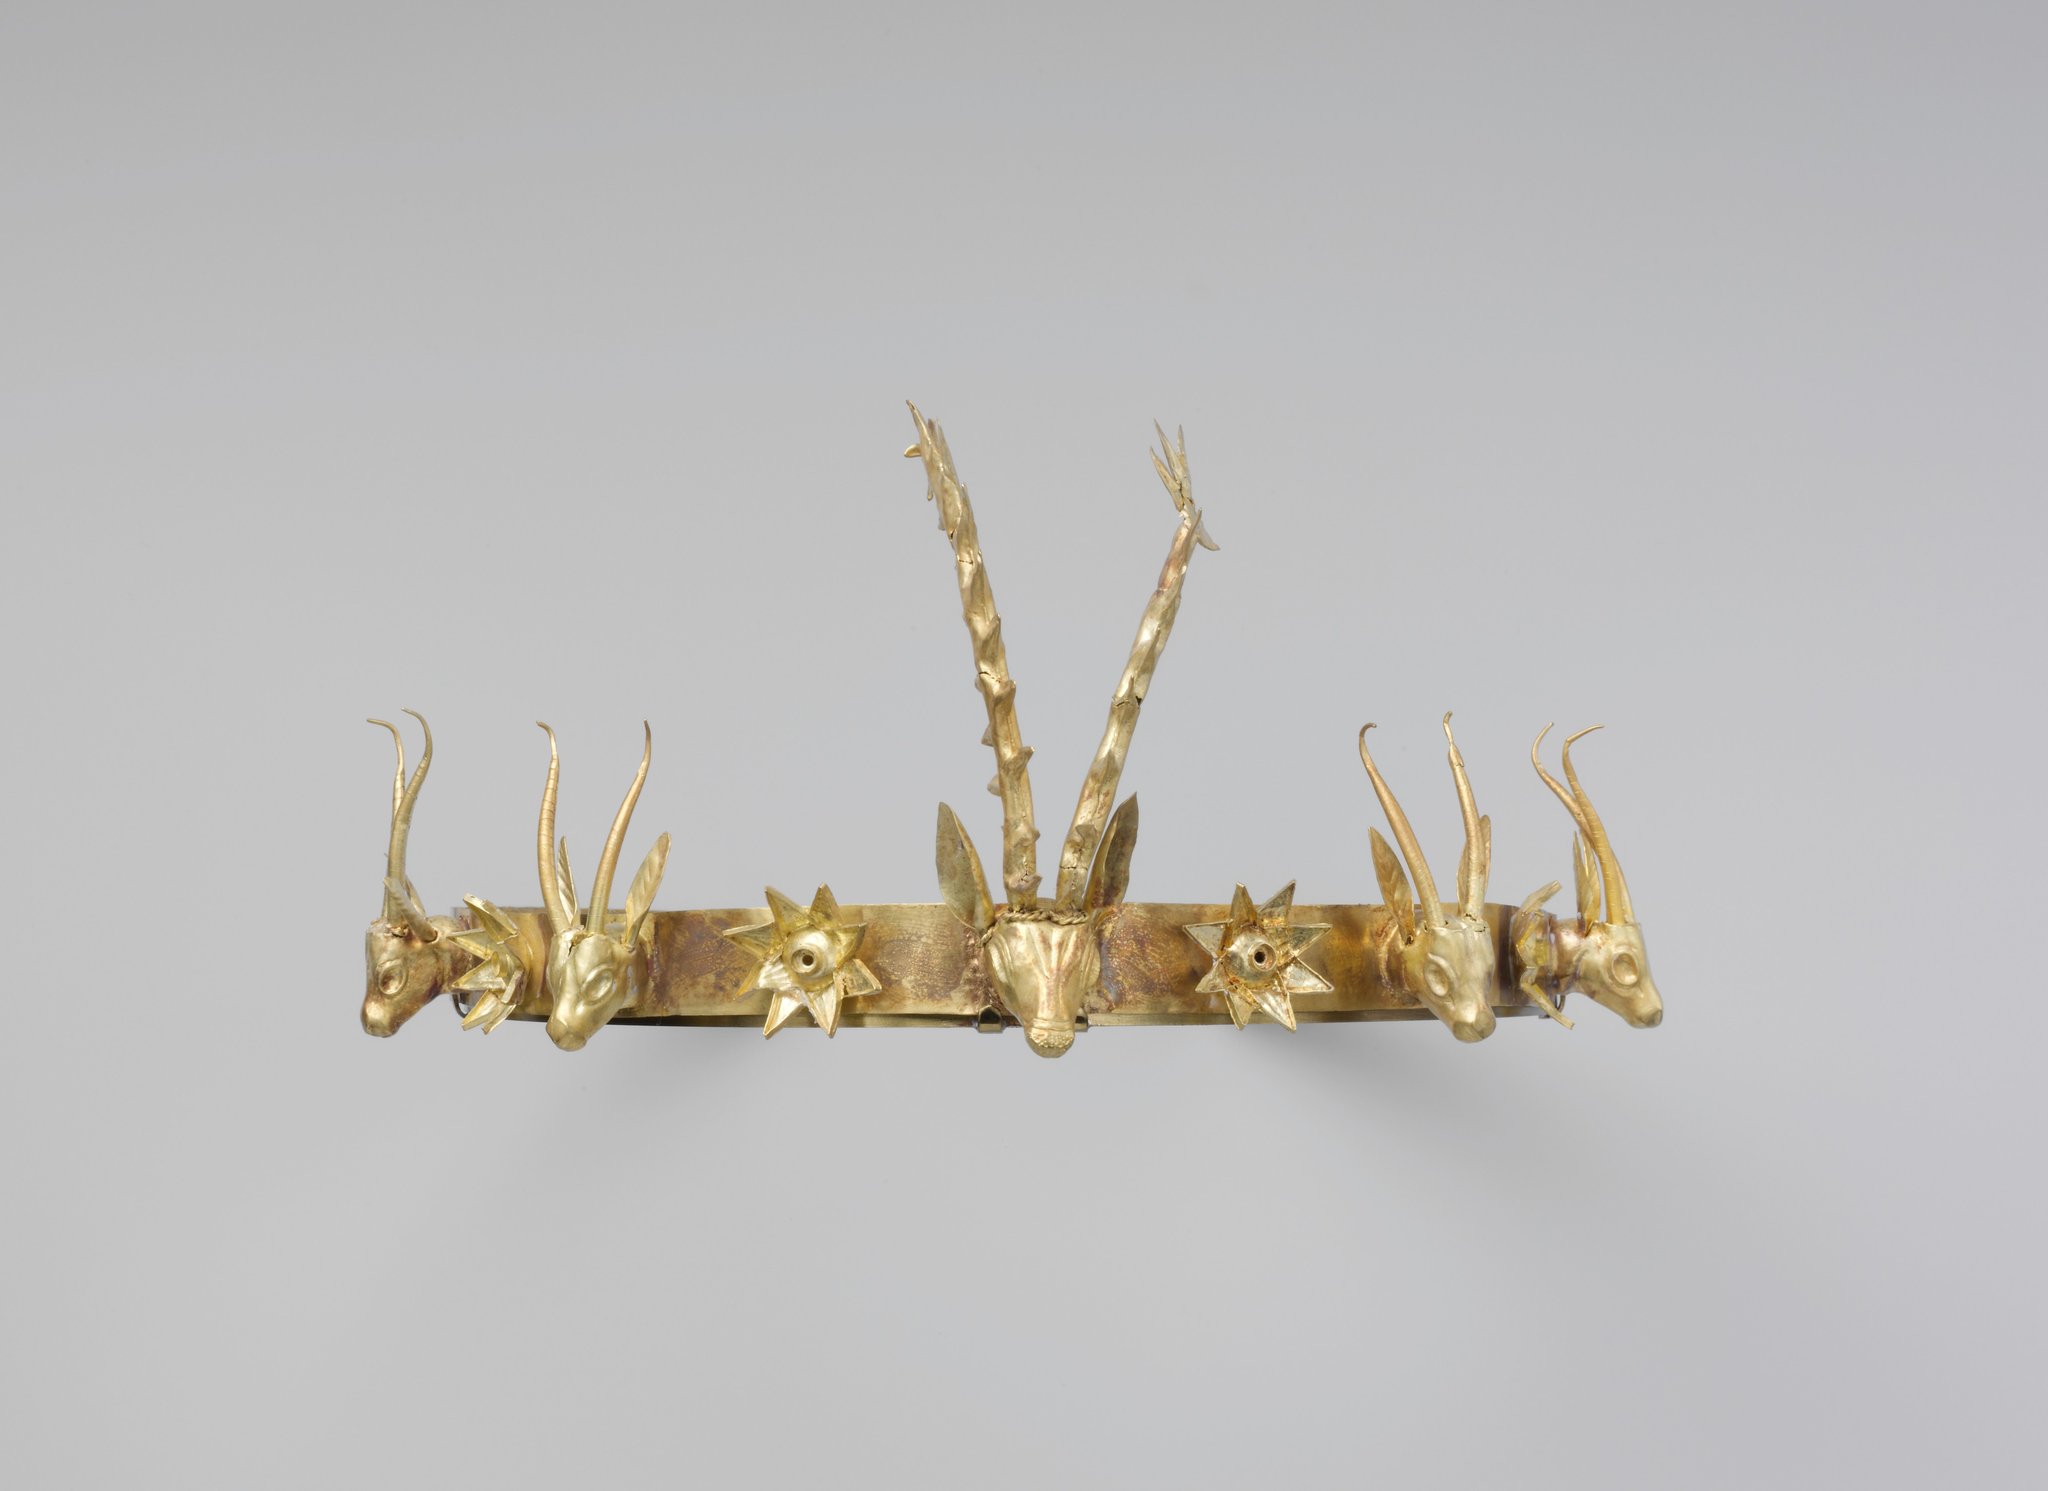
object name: diadem, gazelle, stag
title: Headband with Heads of Gazelles and a Stag Between Stars or Flowers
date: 1648-1540 BCE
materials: gold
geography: eastern delta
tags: animals,flowers